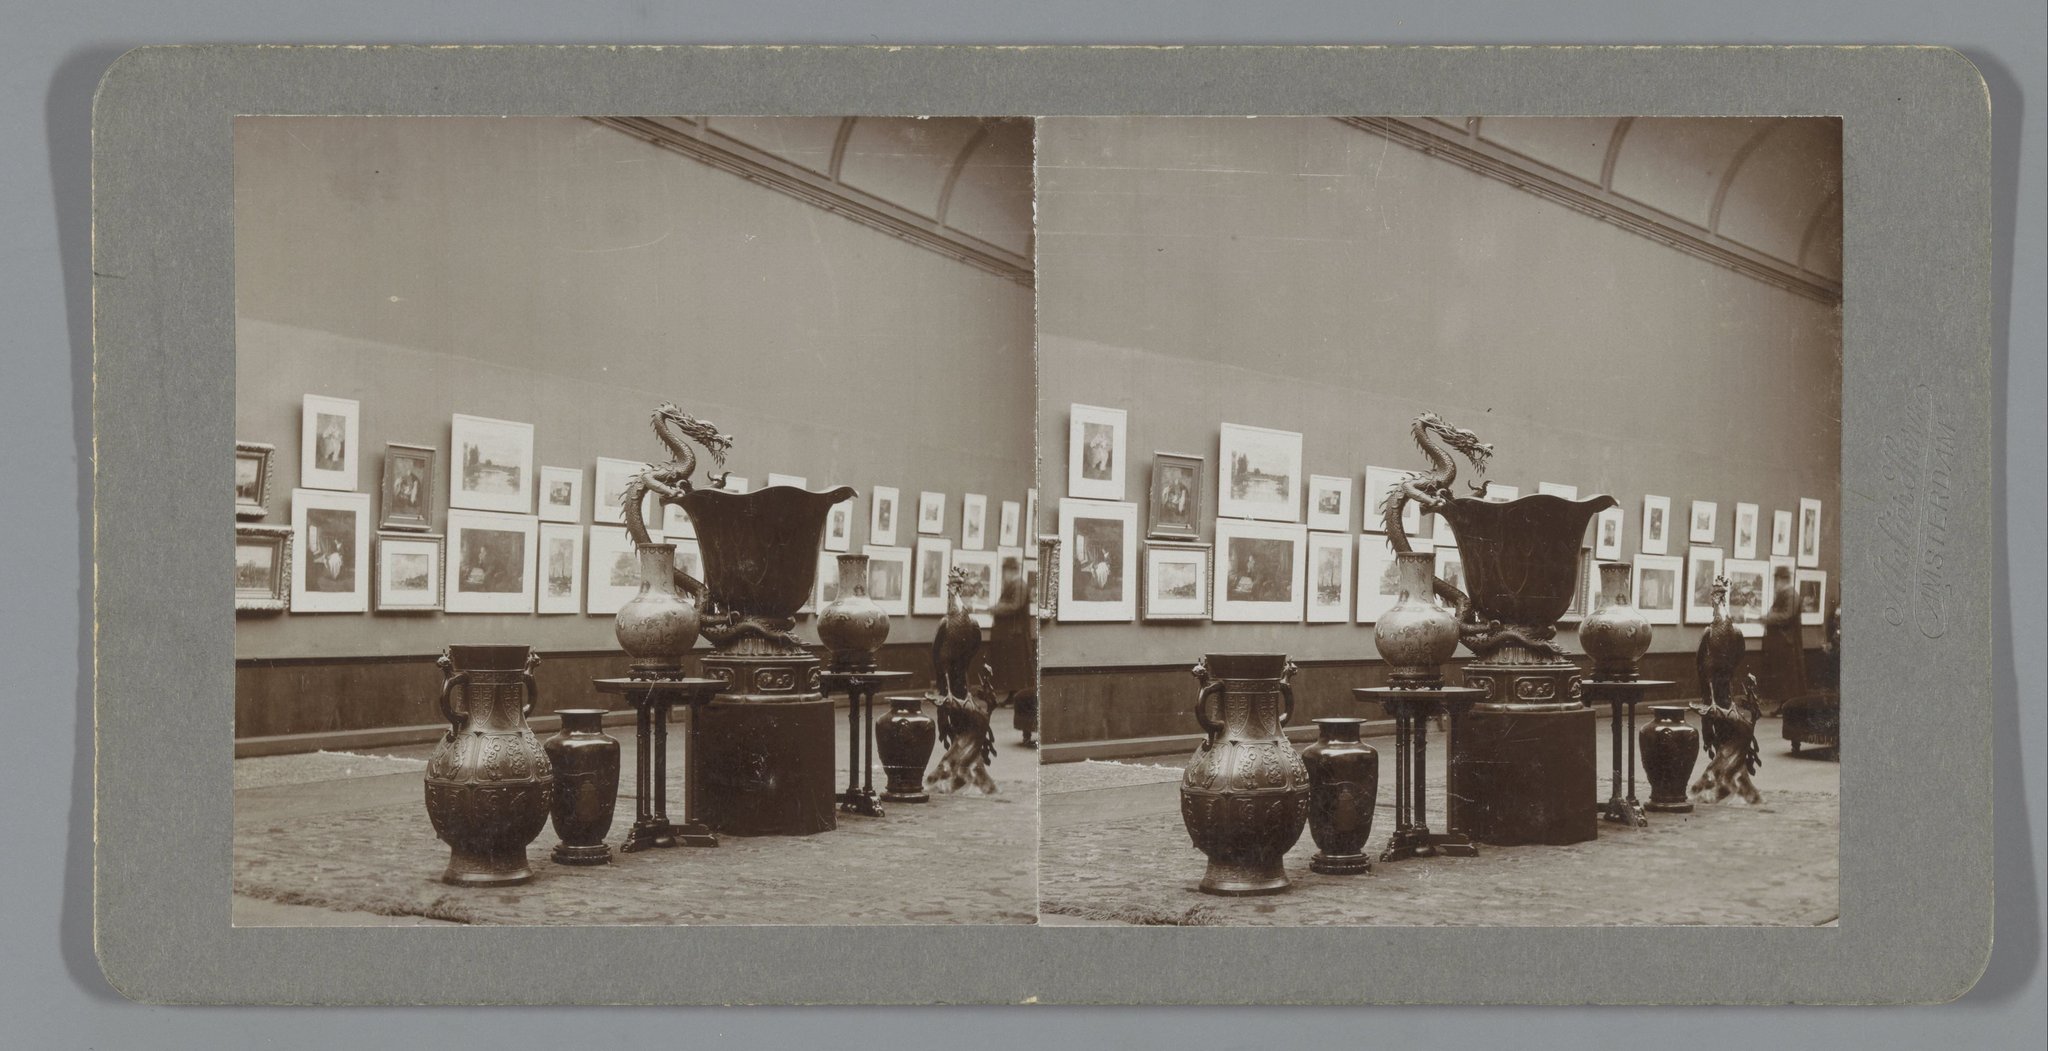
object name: stereograph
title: Gezicht in een zaal van het Stedelijk Museum, Amsterdam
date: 1902-1920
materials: paper, cardboard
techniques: gelatin silver print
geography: amsterdam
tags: collection, exhibition, show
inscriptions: inscription: ‘BN.’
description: Tijdens een tentoonstelling van de Vereeniging tot het Vormen van eene openbare verzameling van Hedendaagsche Kunst (VVHK, ook wel de 'vereeniging met de lange naam' genoemd).